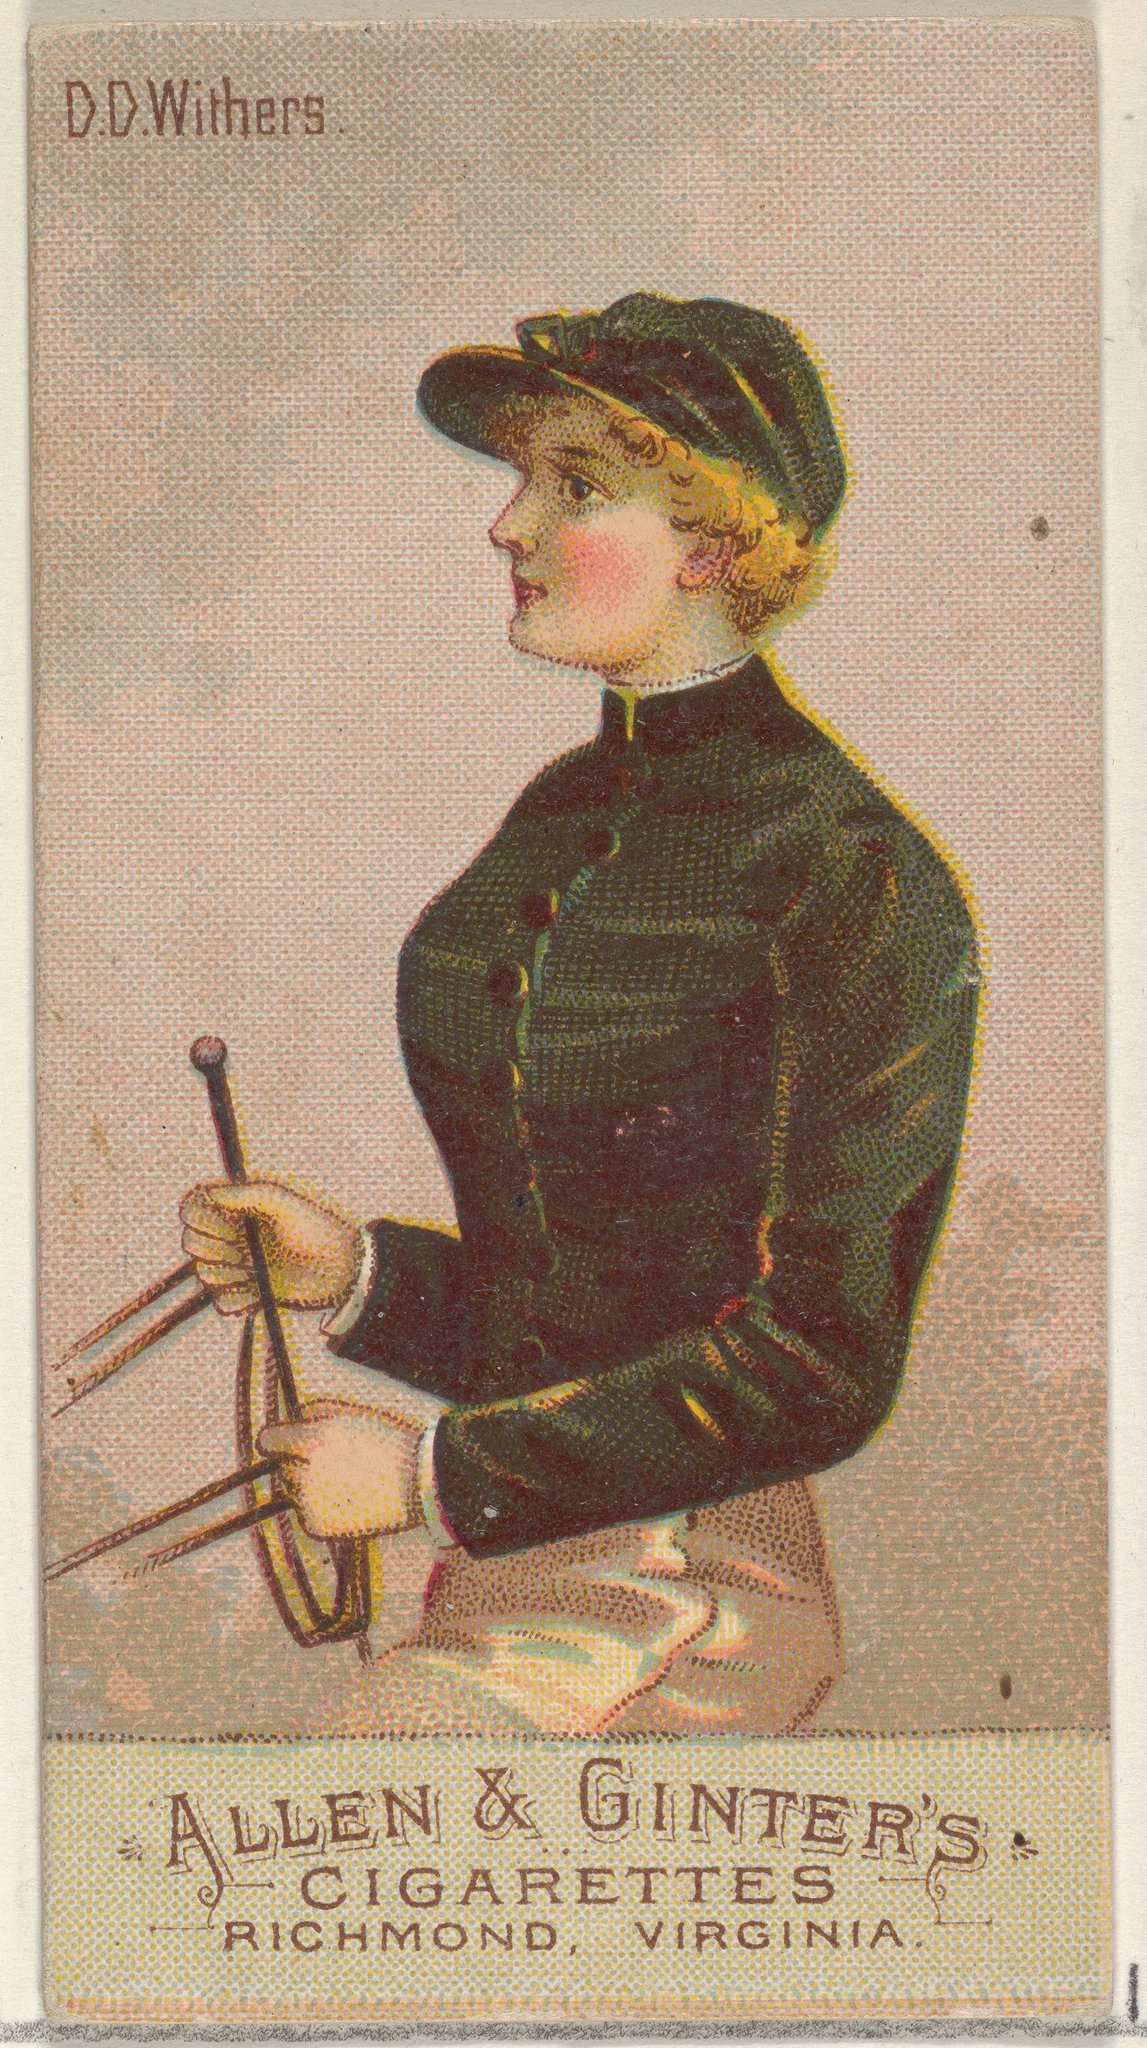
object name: print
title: D.D. Withers, from the Racing Colors of the World series (N22b) for Allen & Ginter Cigarettes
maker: allen & ginter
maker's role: publisher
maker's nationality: american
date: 1888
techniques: color lithograph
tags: profiles,women,jockeys